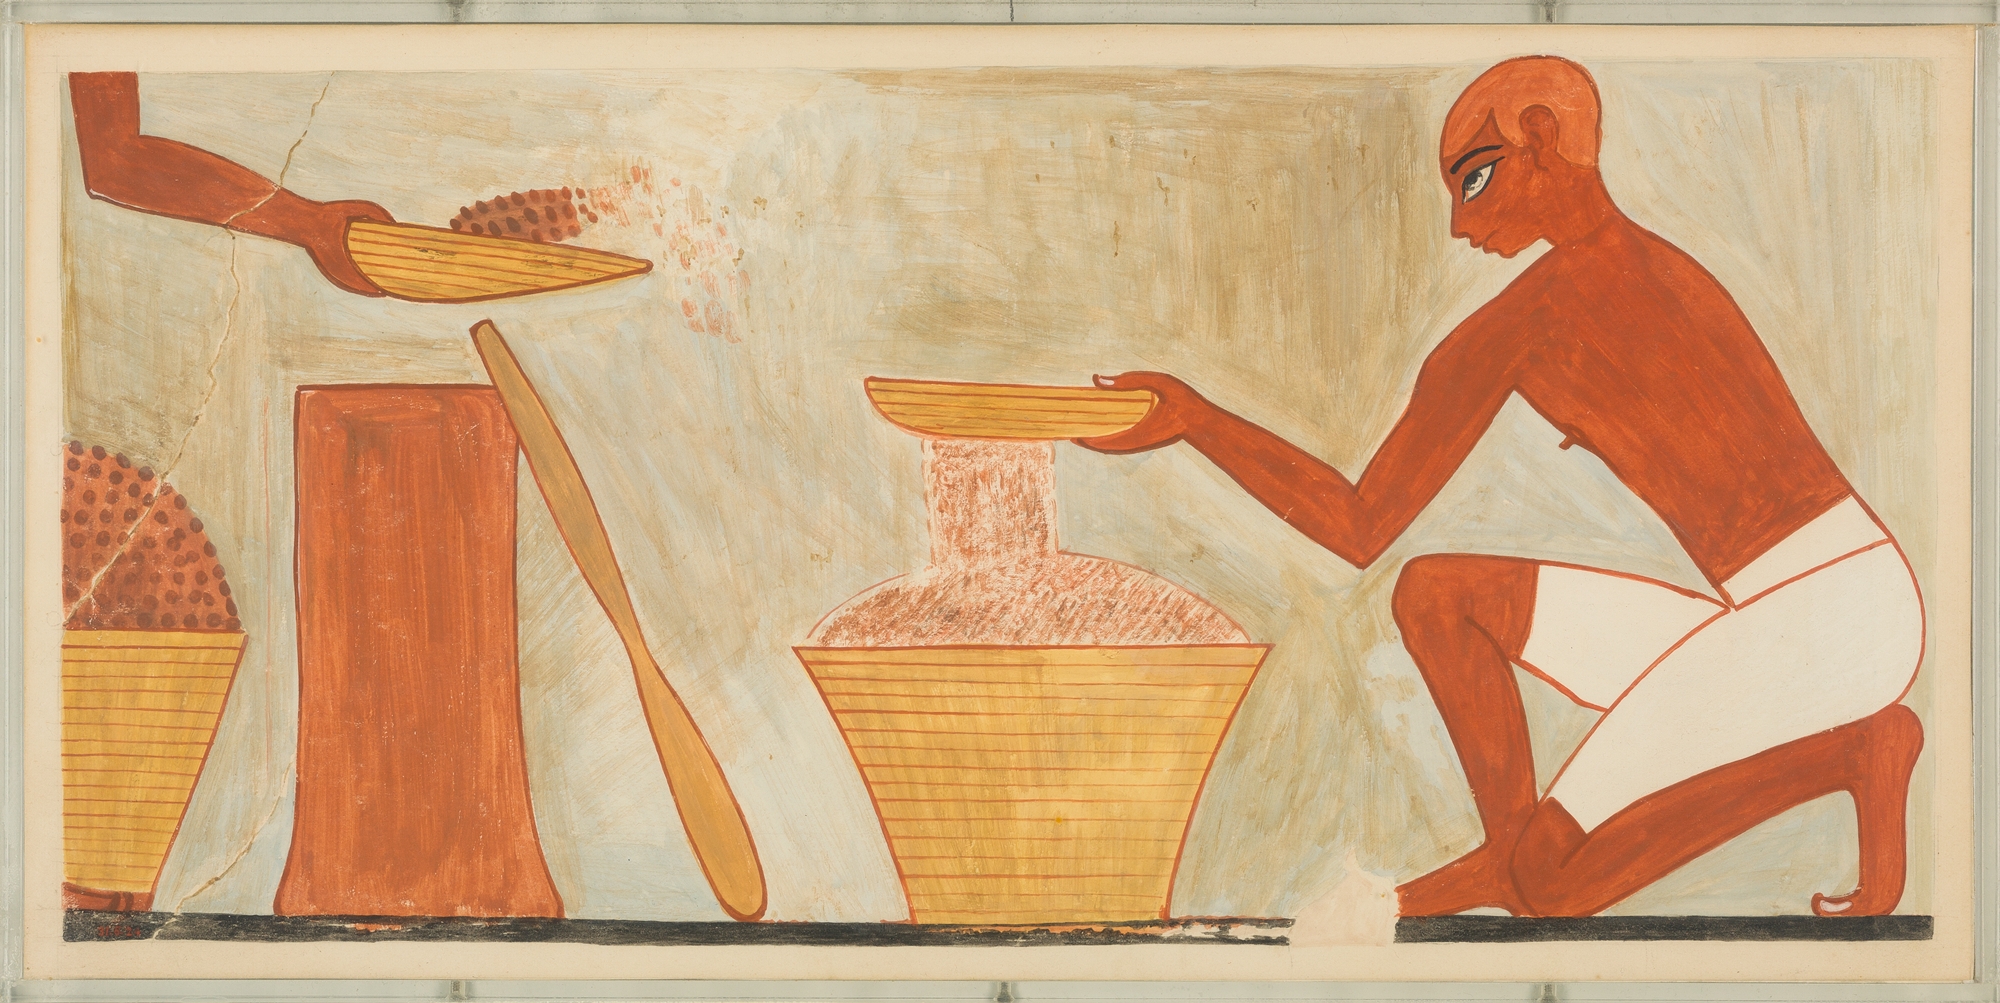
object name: facsimile, rekhmire tt 100, cooking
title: Sifting Meal, Tomb of Rekhmire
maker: nina de garis davies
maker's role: artist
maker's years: 1881-1965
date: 1504-1425 BCE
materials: ink, paint, paper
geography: egypt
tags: food,men,daily life,working,baskets